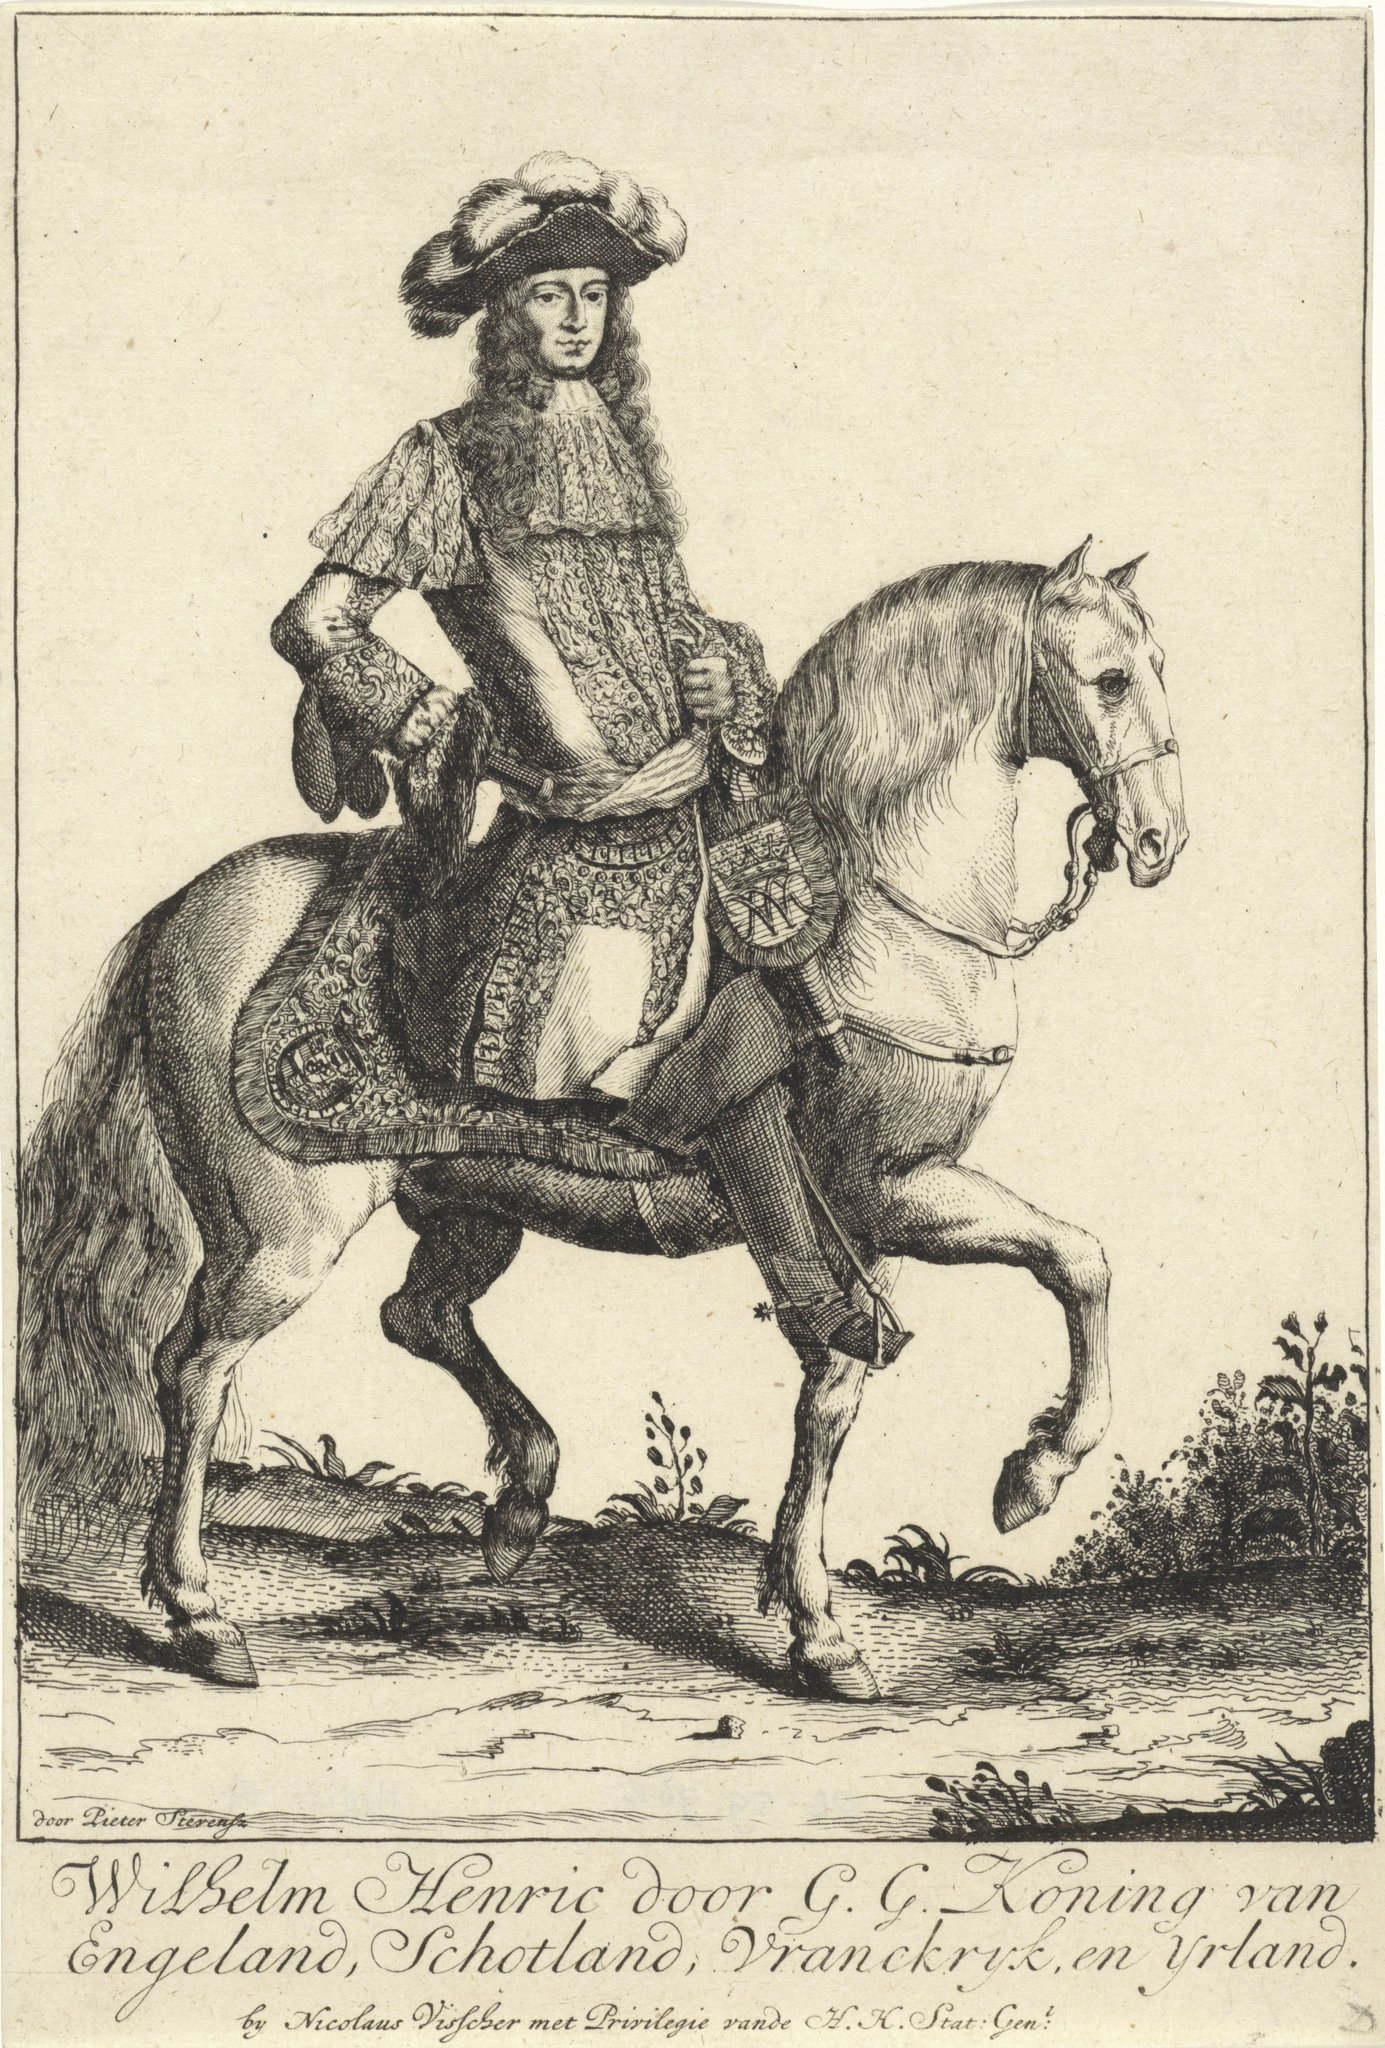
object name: print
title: Ruiterportret van Willem III, prins van Oranje-Nassau en koning van Engeland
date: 1689-1702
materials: paper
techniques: engraving, etching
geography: amsterdam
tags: william iii (prince of orange and king of england, scotland, and ireland), equestrian state-portrait, prince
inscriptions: collector's mark: Lugt 2228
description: Portret van Willem III, prins van Oranje-Nassau en koning van Engeland, te paard. Onderaan in de marge zijn naam en functie in het Nederlands.